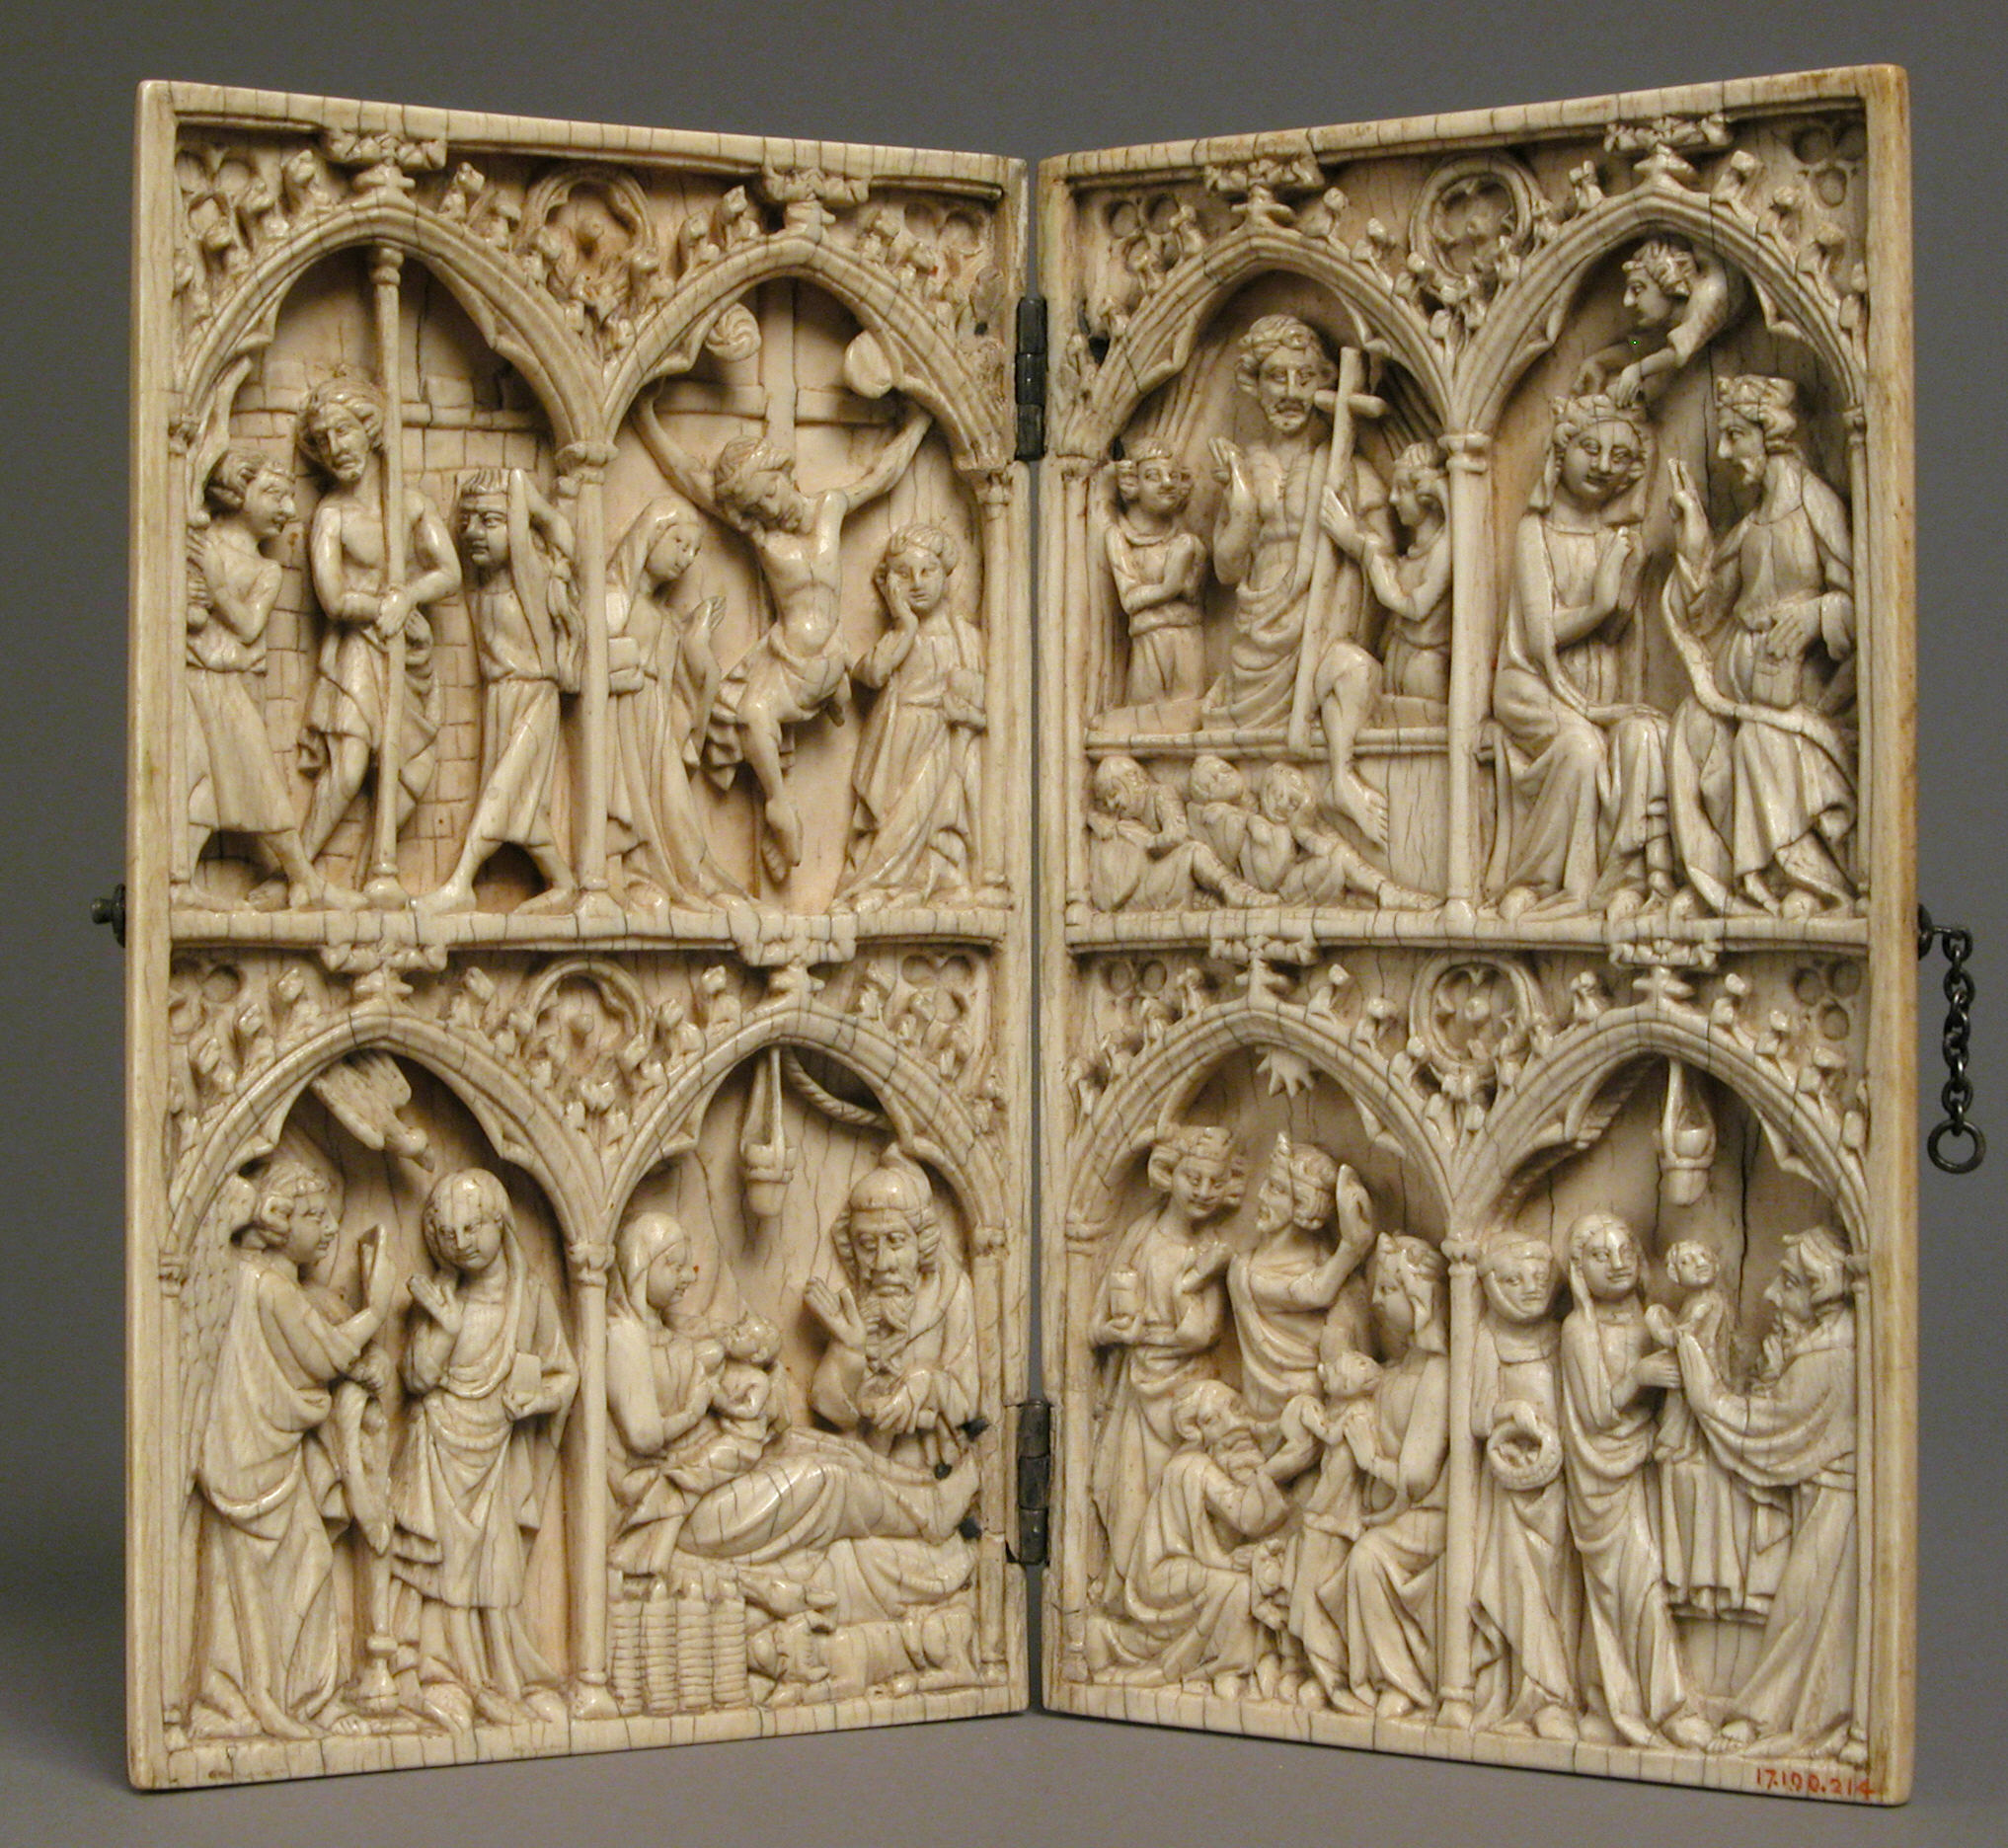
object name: diptych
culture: french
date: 1301-1400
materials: ivory, metal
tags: angels,christ,virgin mary,annunciation,crucifixion,nativity,resurrection